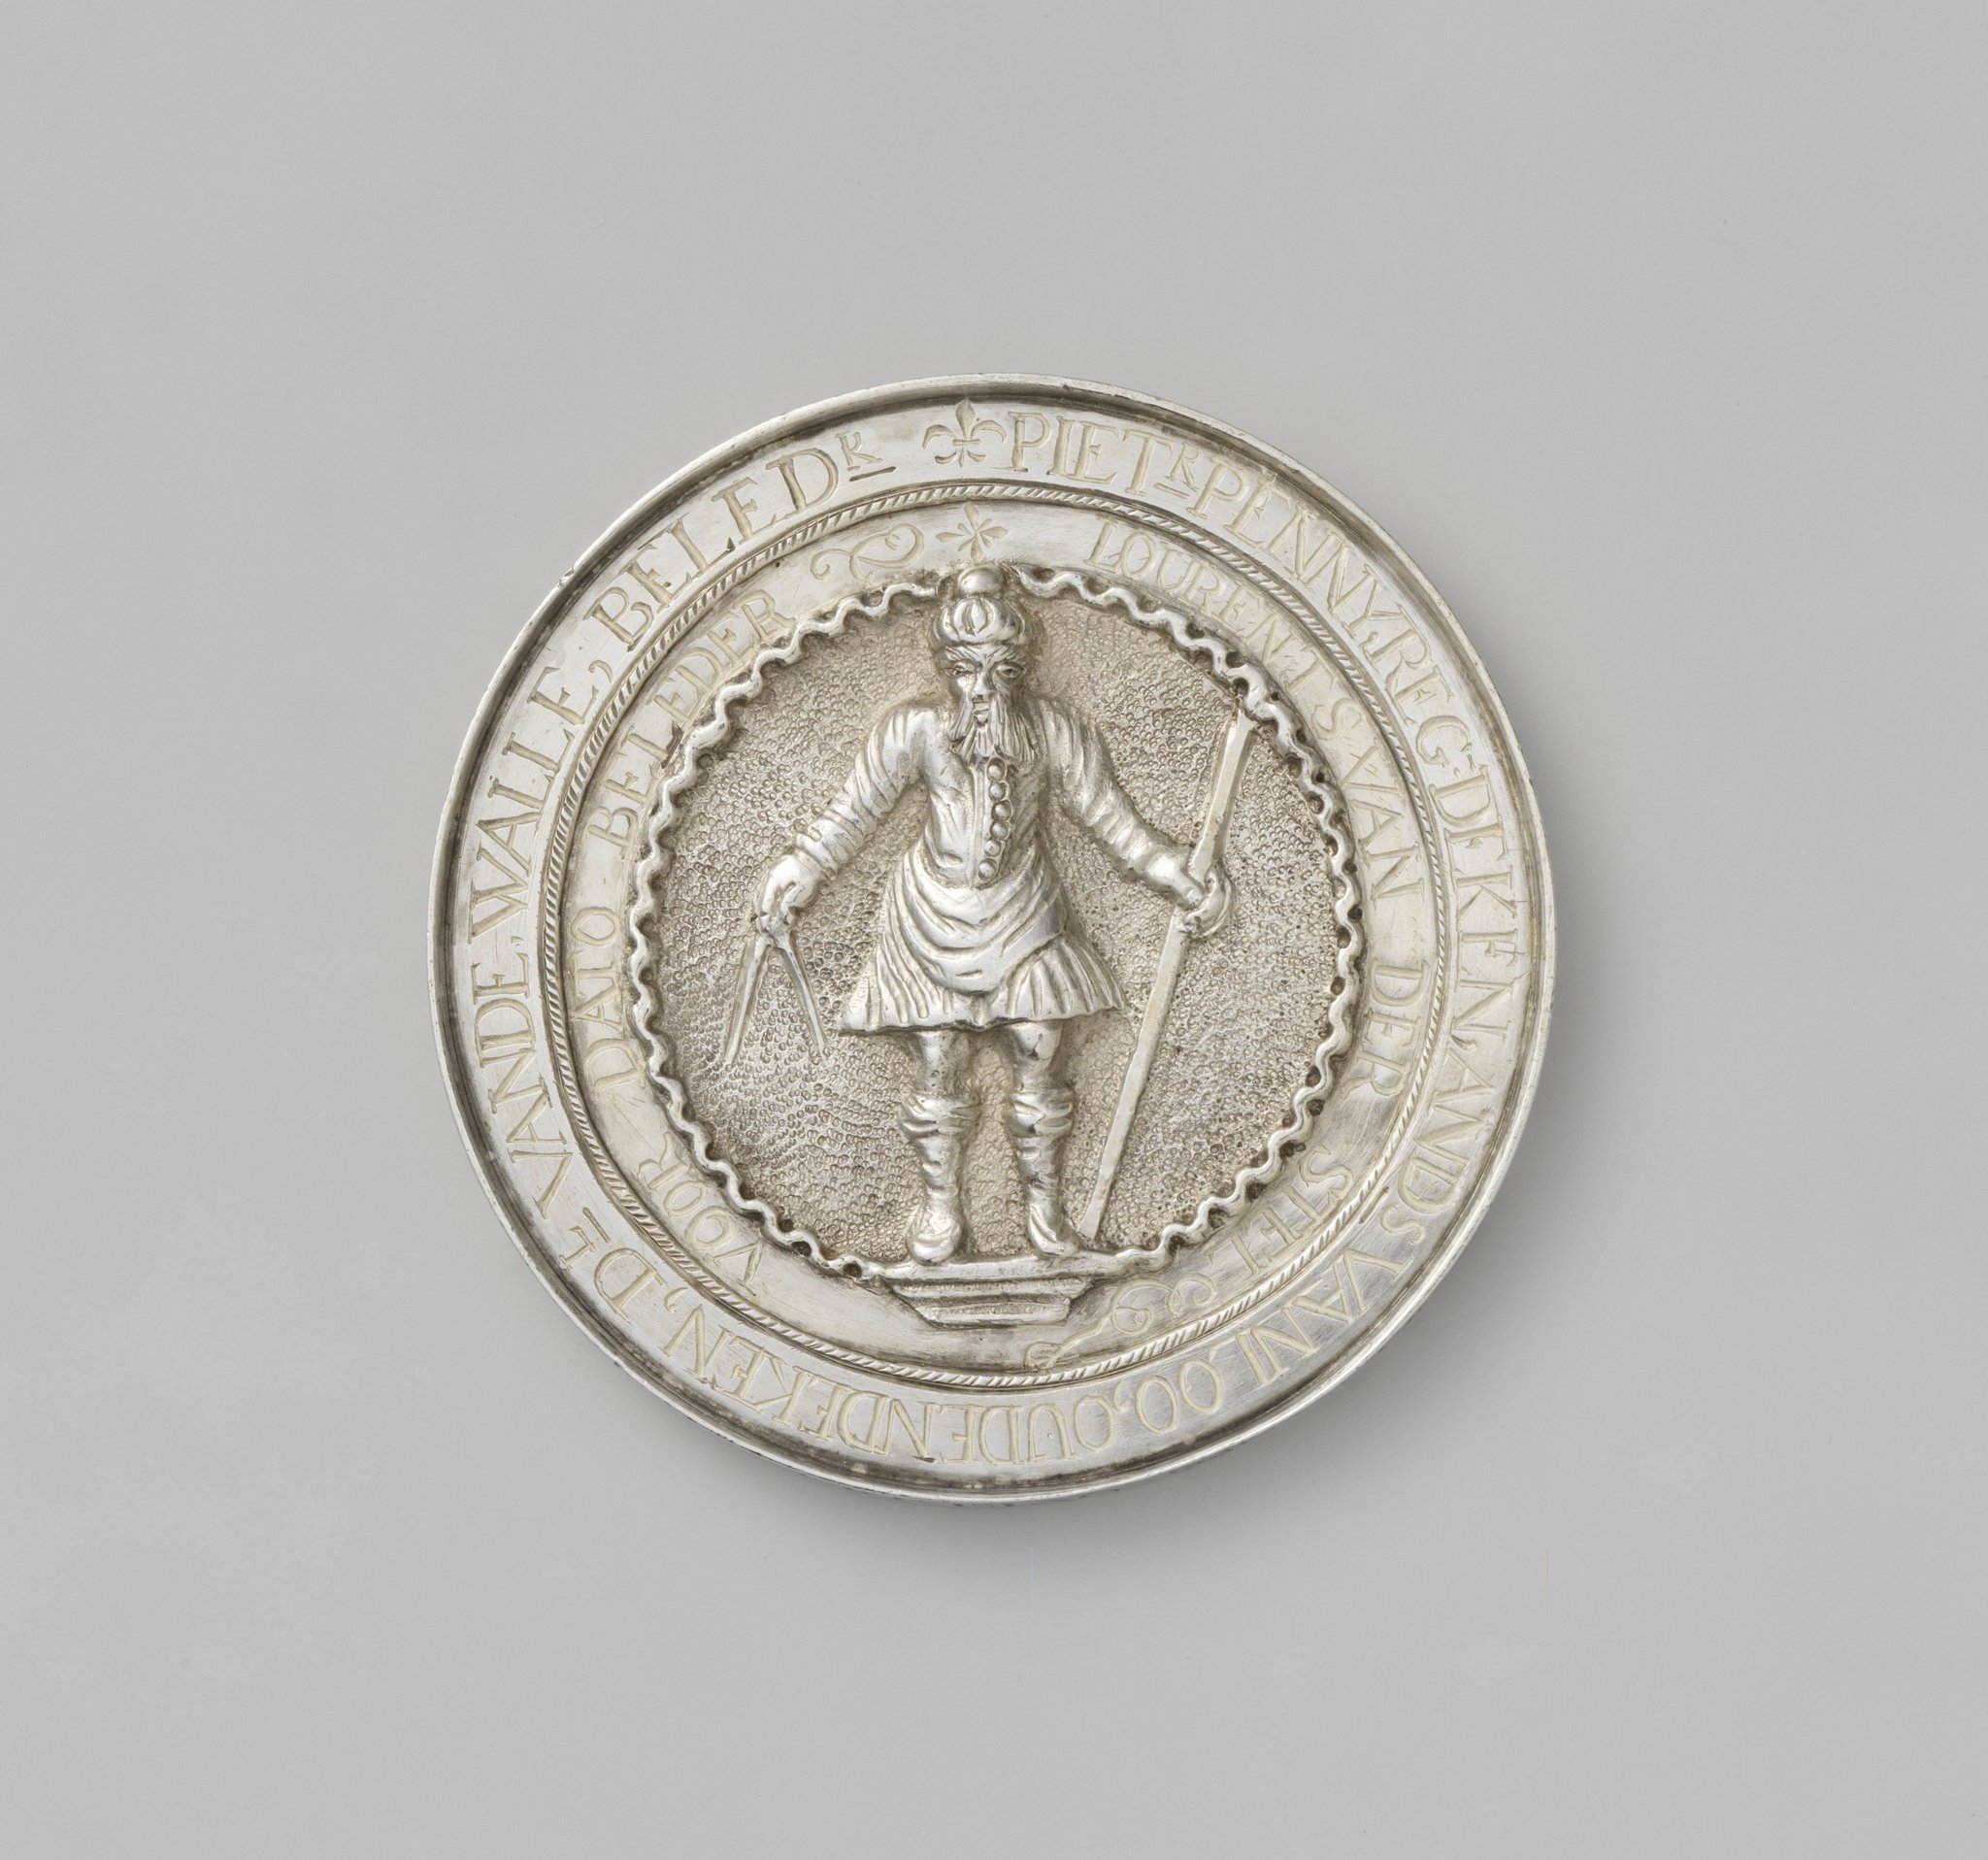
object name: medal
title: Carpenters’ Guild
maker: Anonymous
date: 1738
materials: silver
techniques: casting, engraving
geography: middelburg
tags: middelburg